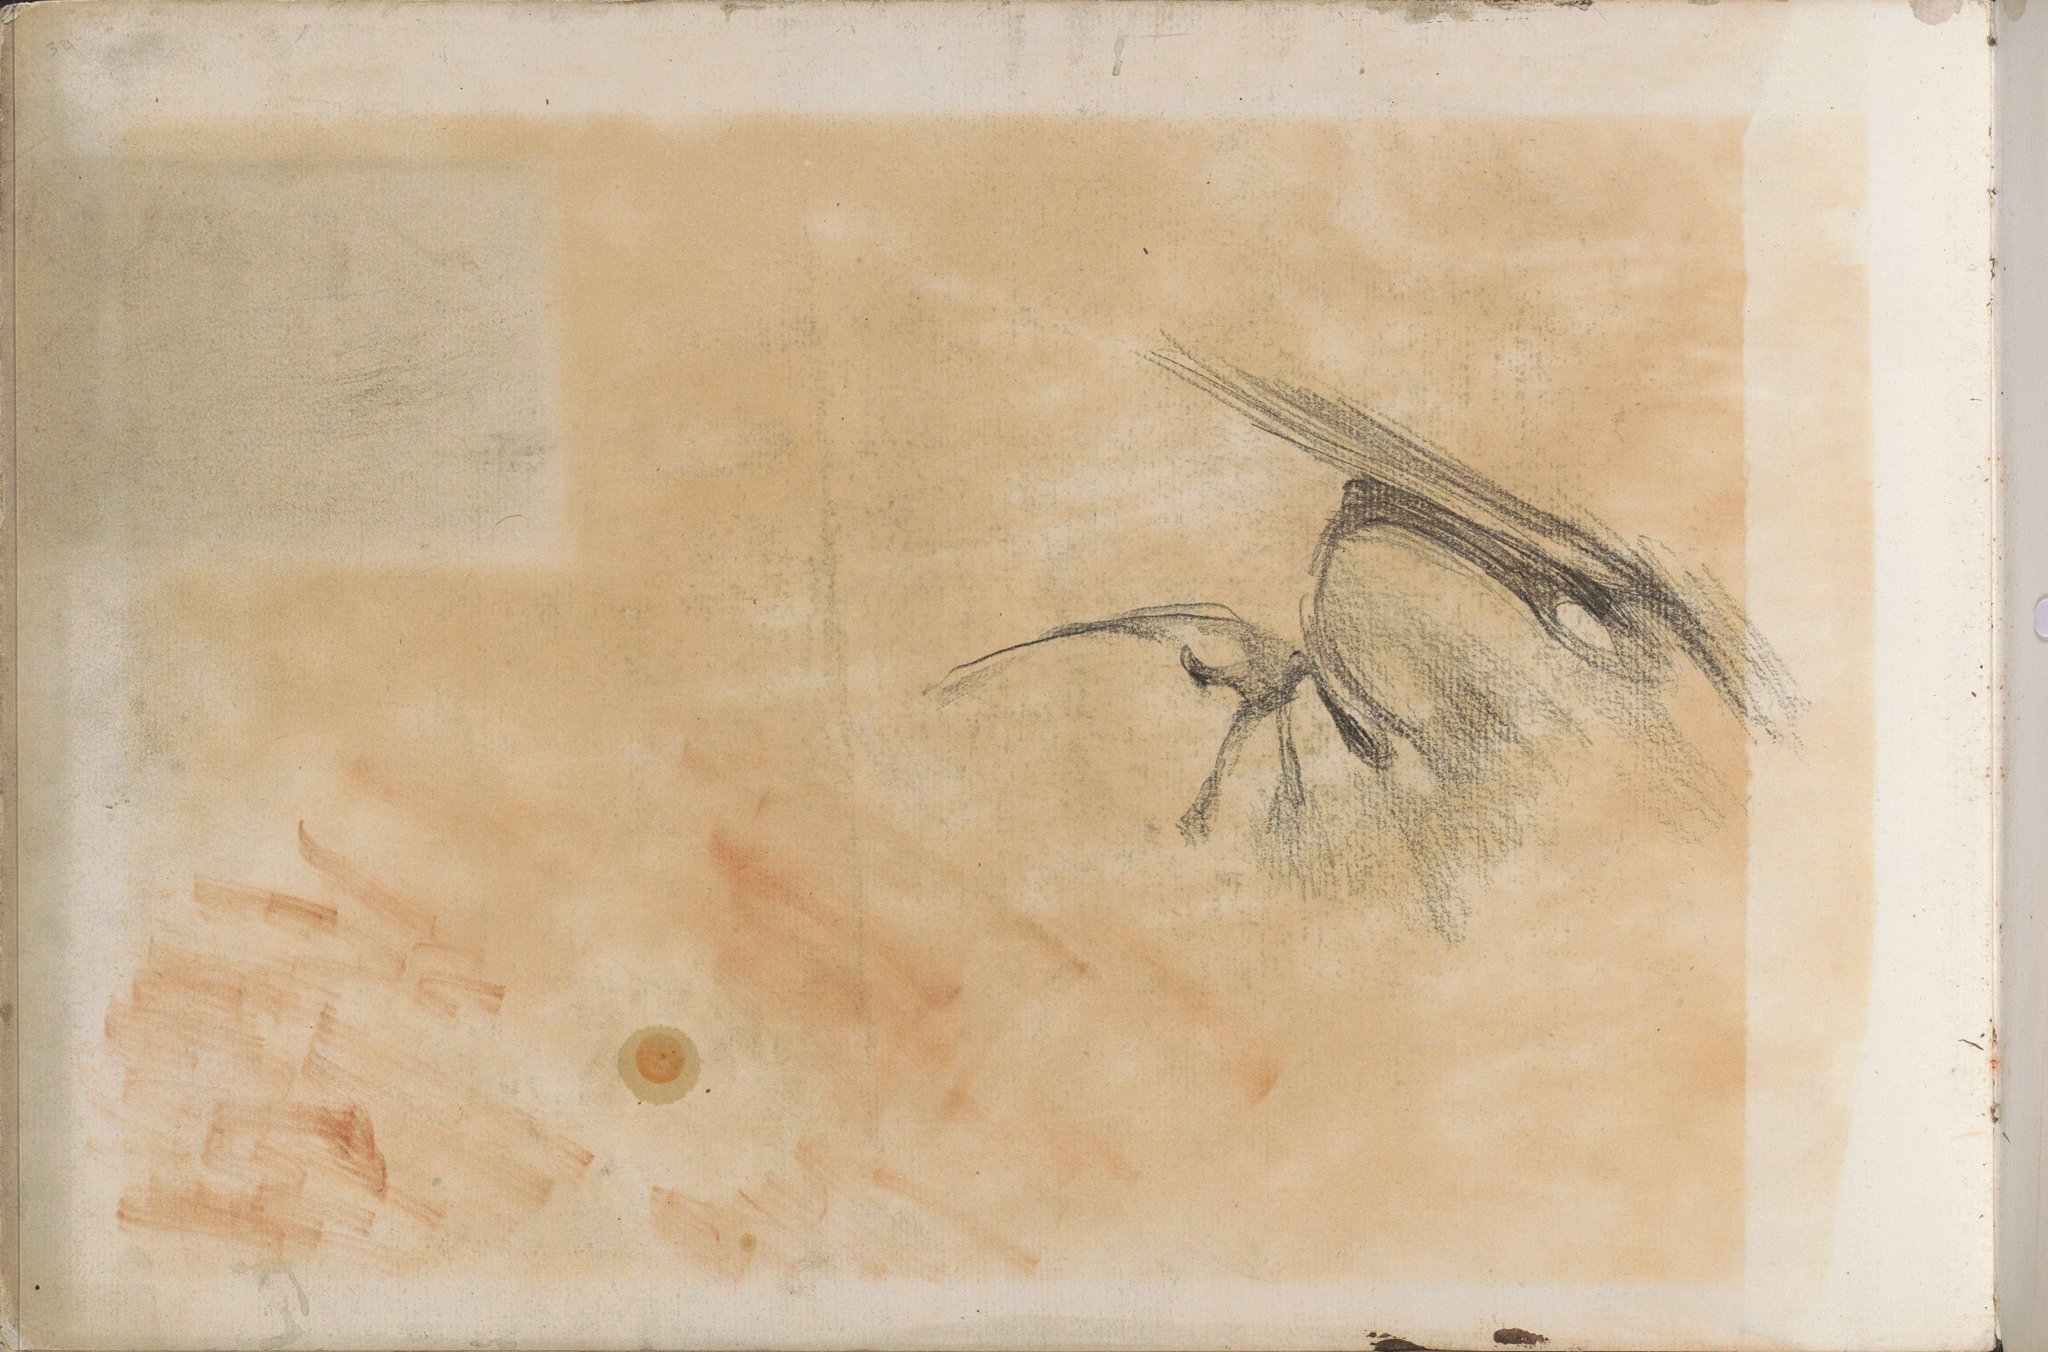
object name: sketchbook leaf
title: Studie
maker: willem witsen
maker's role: draughtsman, painter, print maker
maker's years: 1860-1923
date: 1887-1892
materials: chalk, paper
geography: amsterdam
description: Pagina 34 uit een schetsboek met 17 bladen.